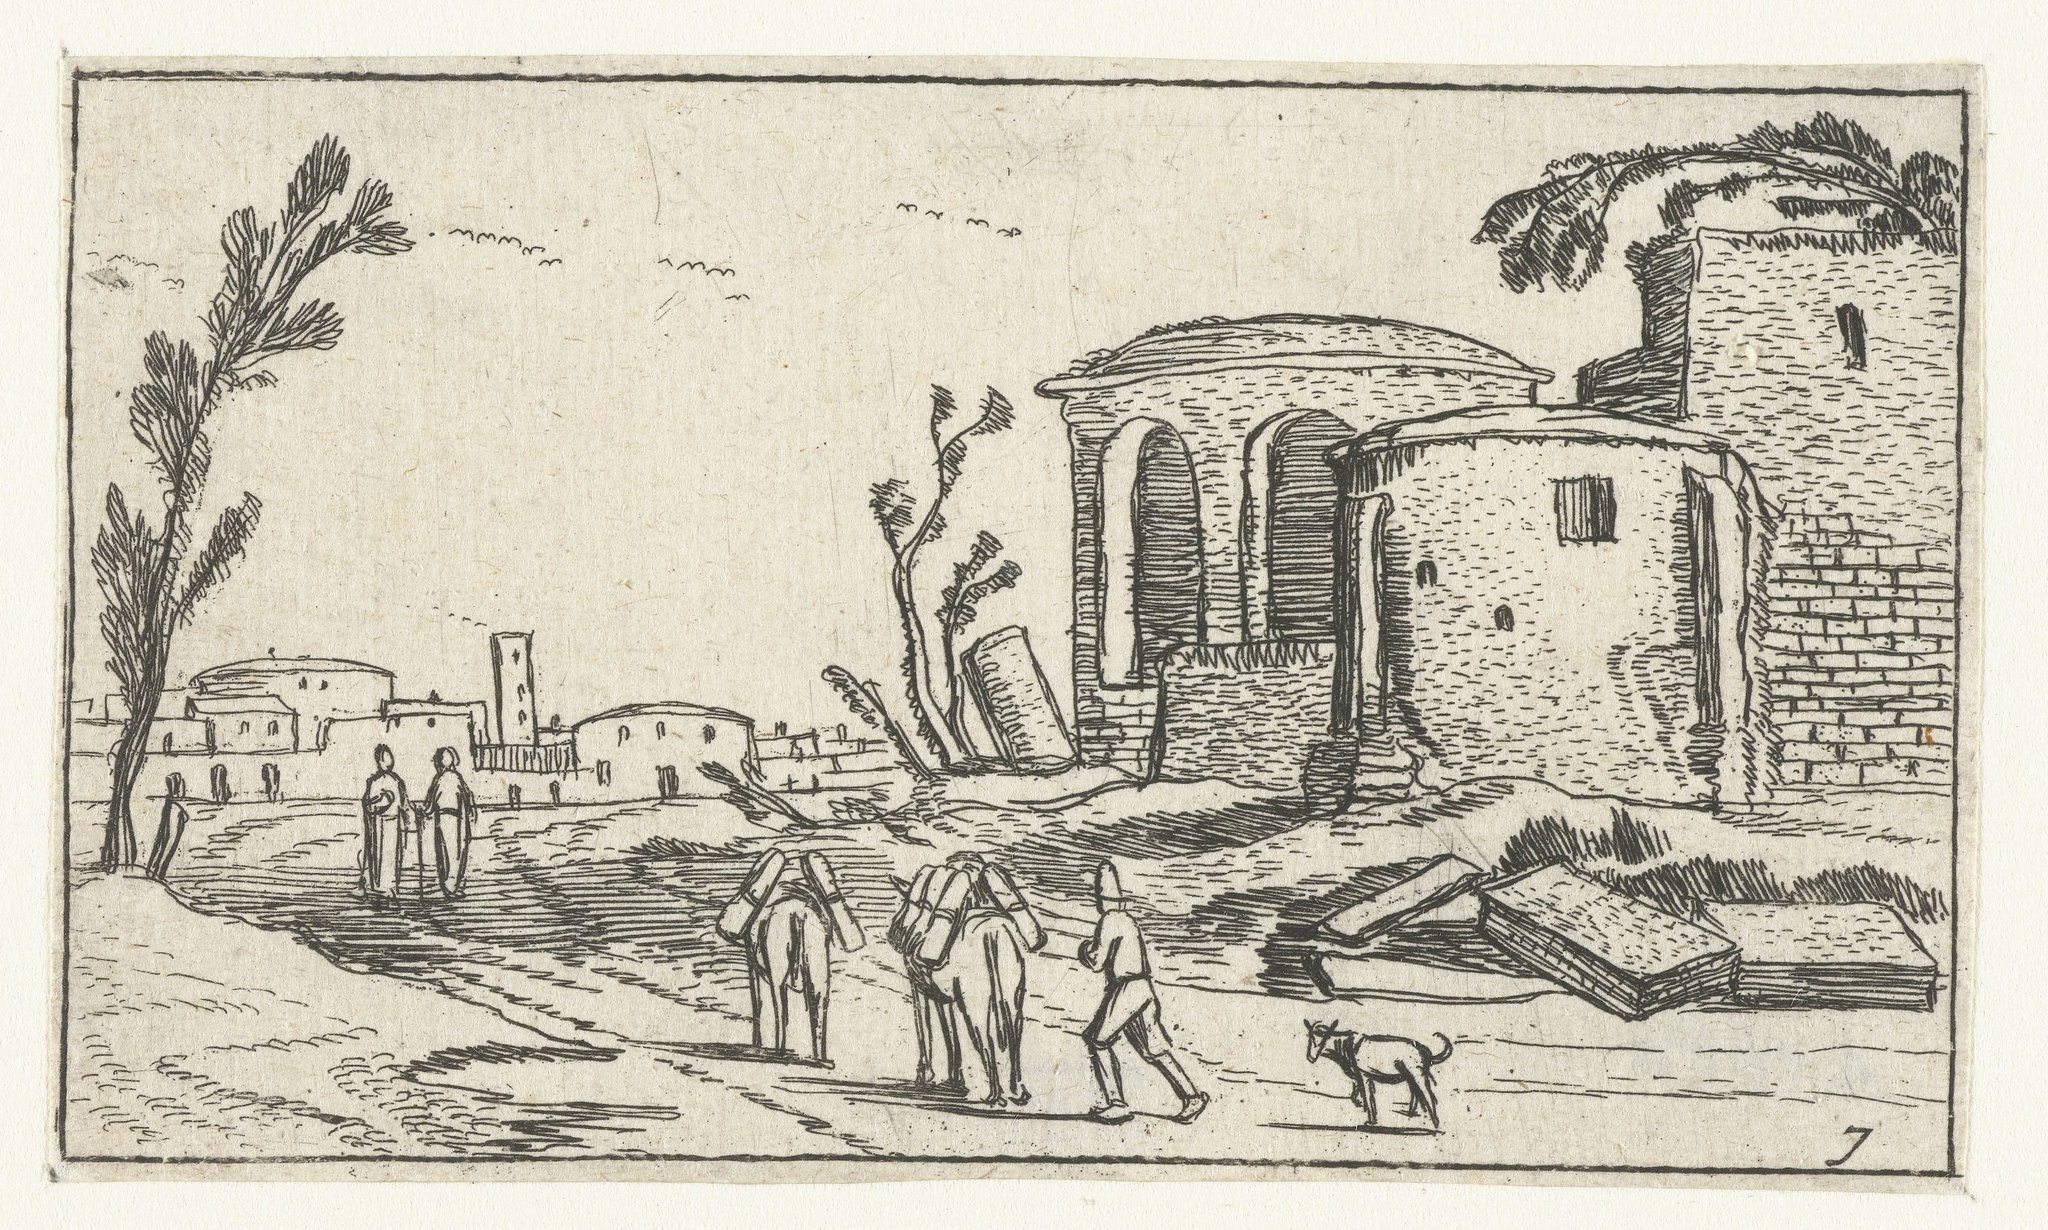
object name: print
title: Landschap met ruïnes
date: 1610-1617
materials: paper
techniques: etching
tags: landscape with ruins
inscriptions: collector's mark: Lugt 2227